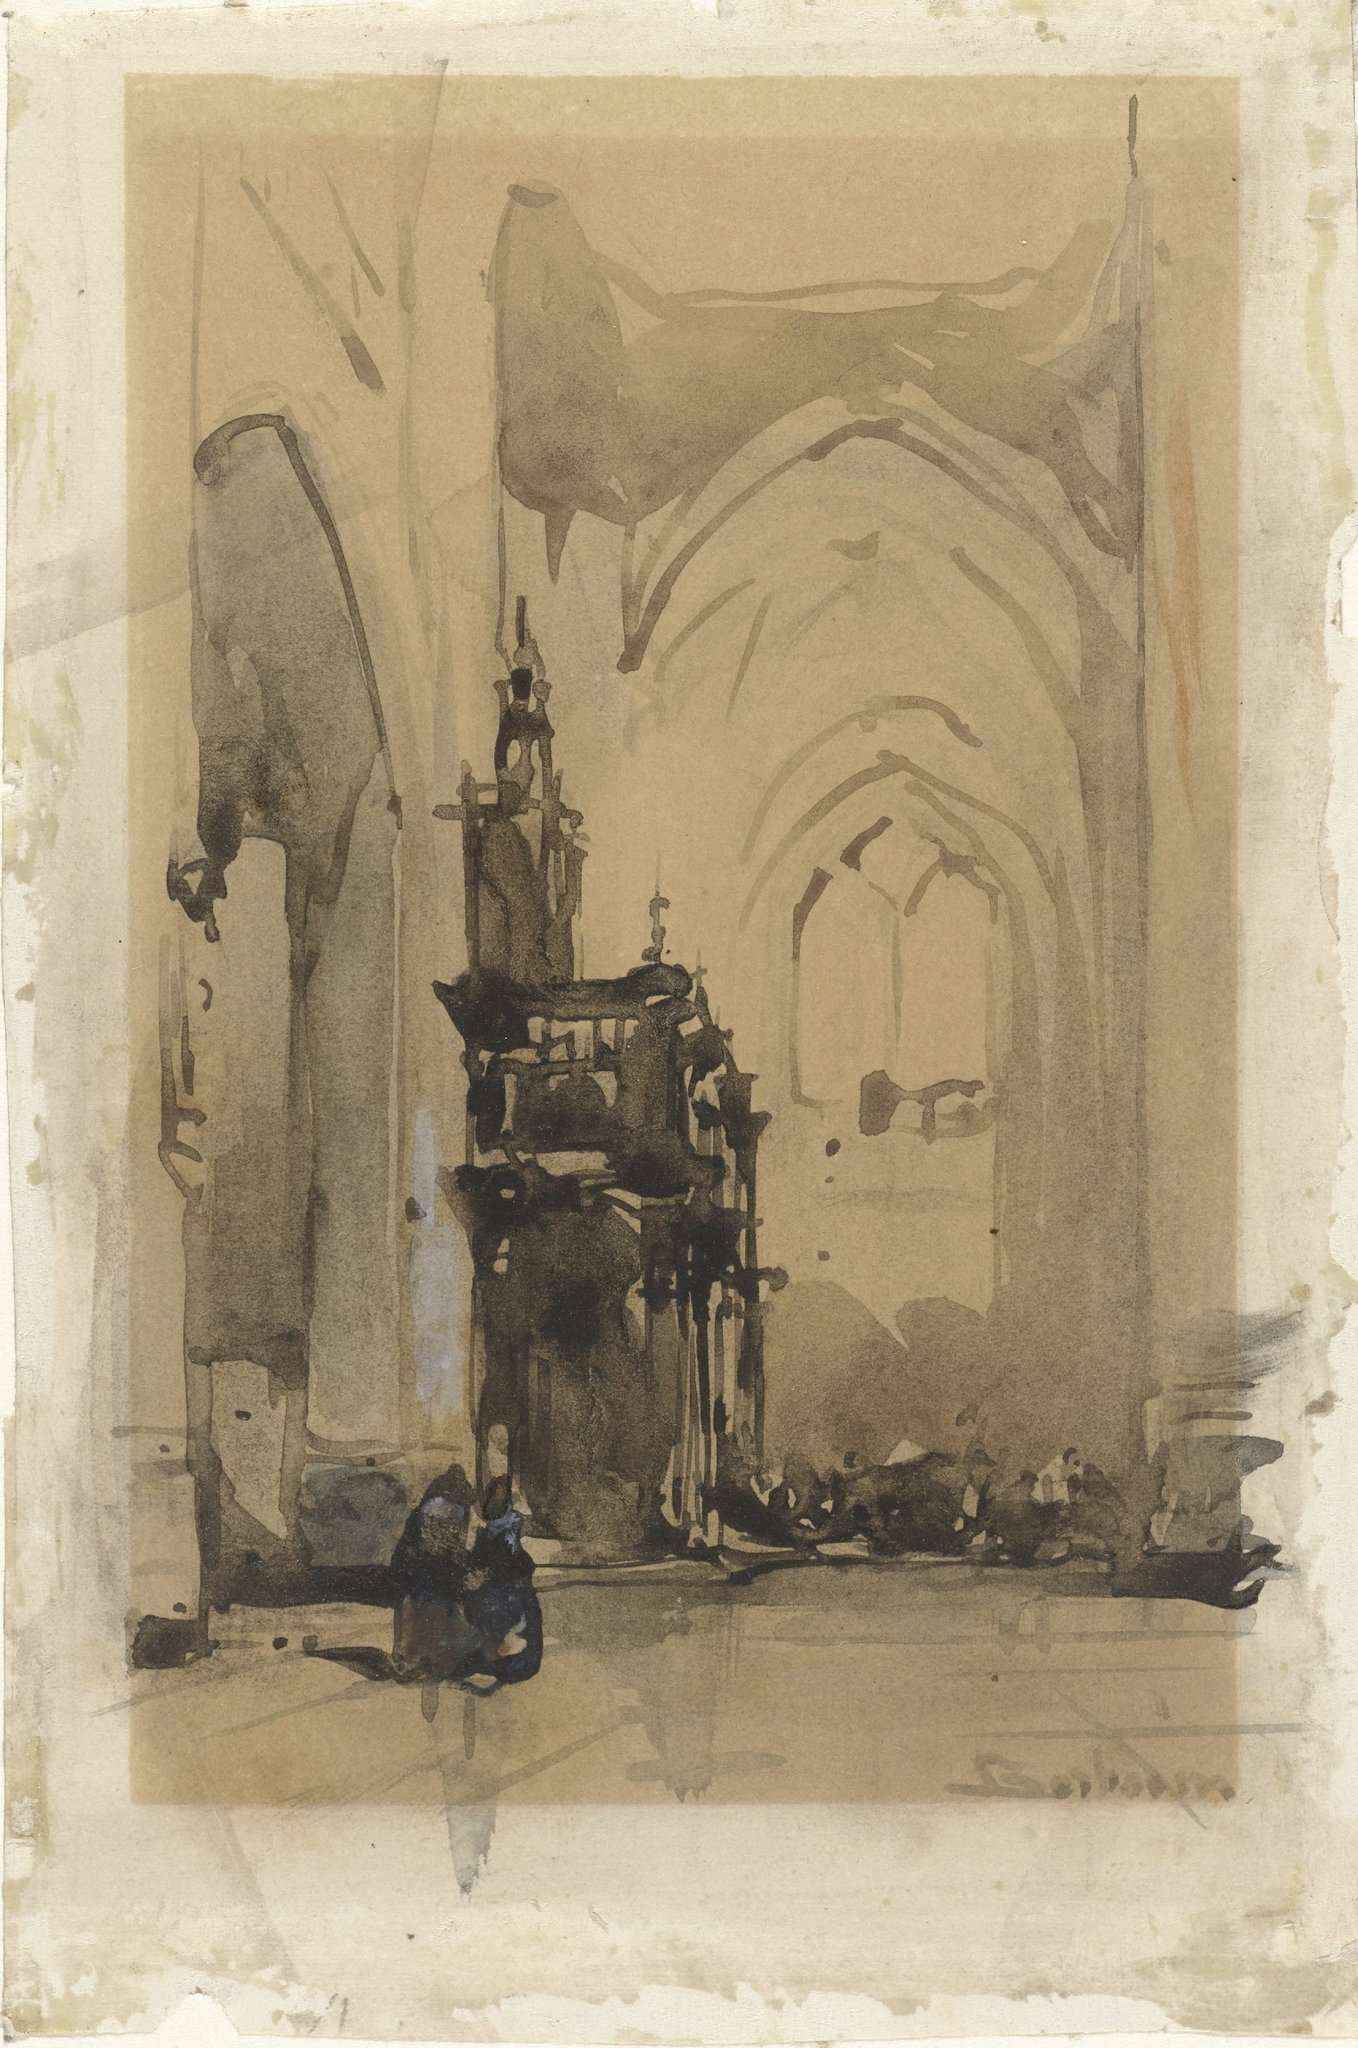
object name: drawing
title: Gezicht op het oxaal van de Sint-Janskathedraal te 's-Hertogenbosch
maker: johannes bosboom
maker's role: draughtsman, painter, print maker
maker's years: 1817-1891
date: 1851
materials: chalk, paint, paper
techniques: brush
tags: interior of church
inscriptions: signature: ‘JBosboom’